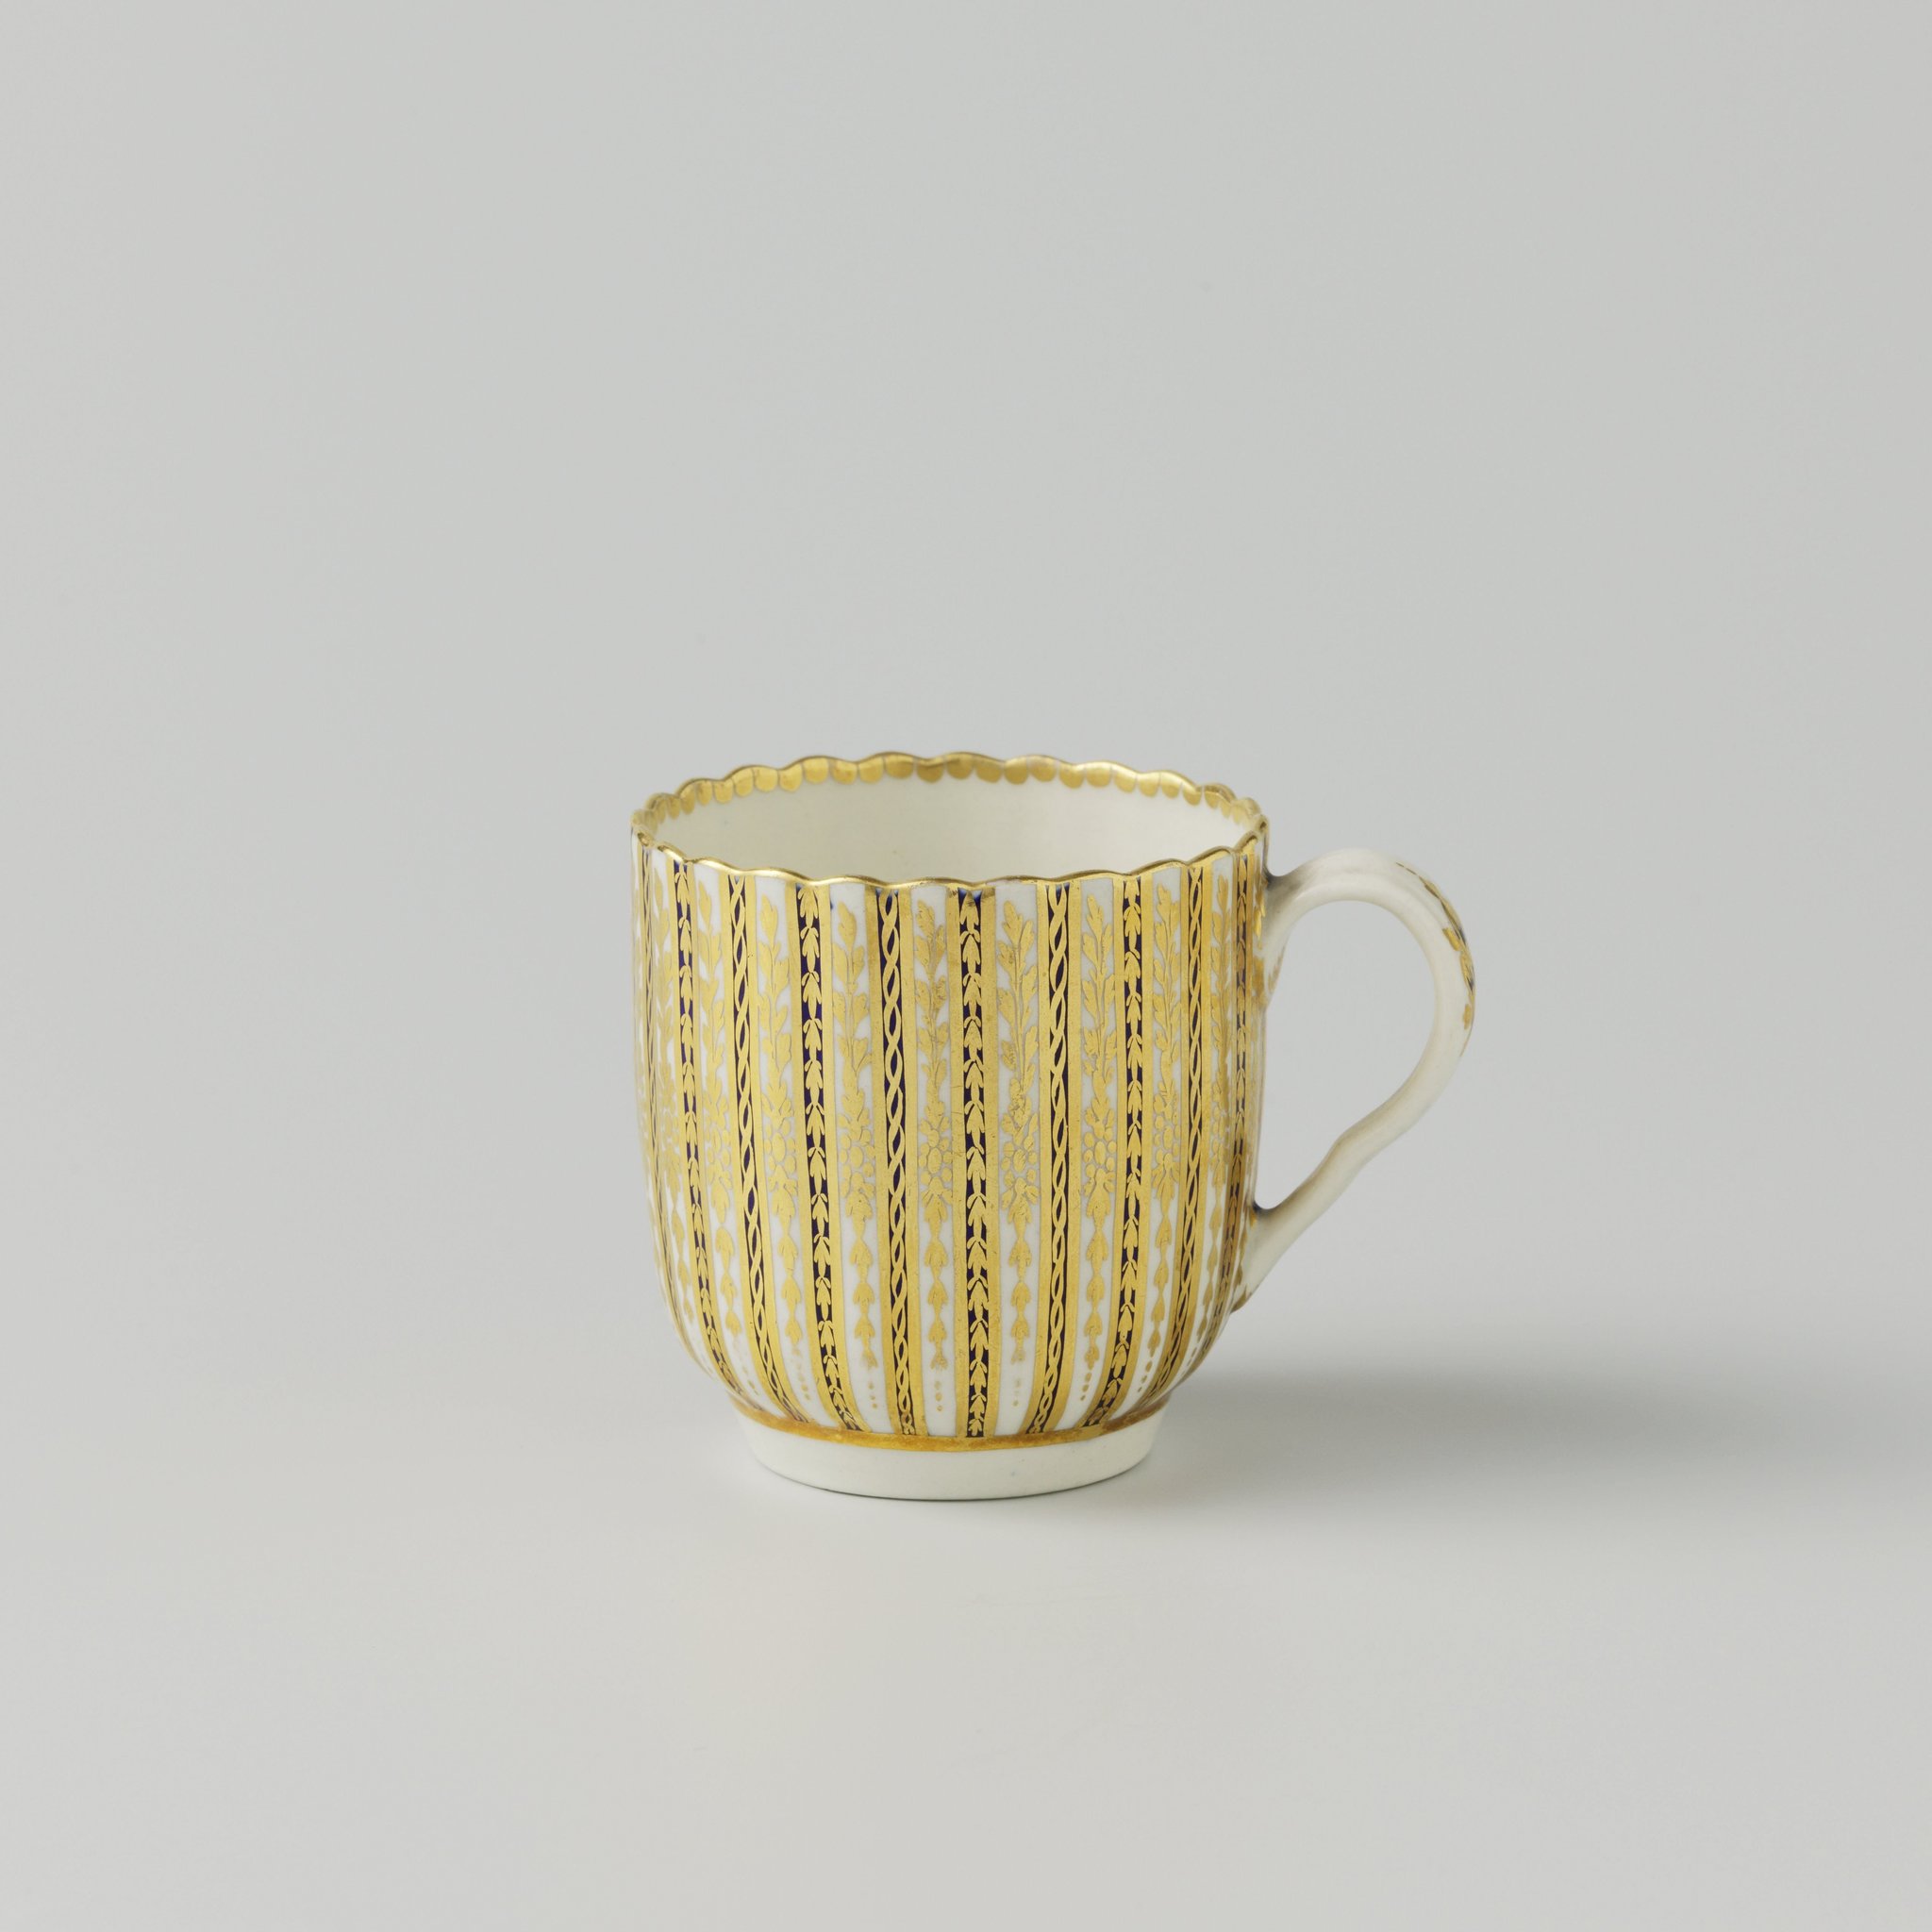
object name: cup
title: Kop, de ribben afwisselend blauw en wit, gescheiden door gouden biezen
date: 1775-1800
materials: earthenware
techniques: vitrification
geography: worcester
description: Kop, geribd, de randen gekarteld. De ribben door verticale gouden biezen gescheiden. De holtes donkerblauw (Blue du Roi), de ribben wit, waarop een versiering van bladwerk en vlechtband. Het oor eenmaal geknikt. De randen verguld, verguldsel naar binnen gekarteld. Gemerkt in onderglazuurblauw.